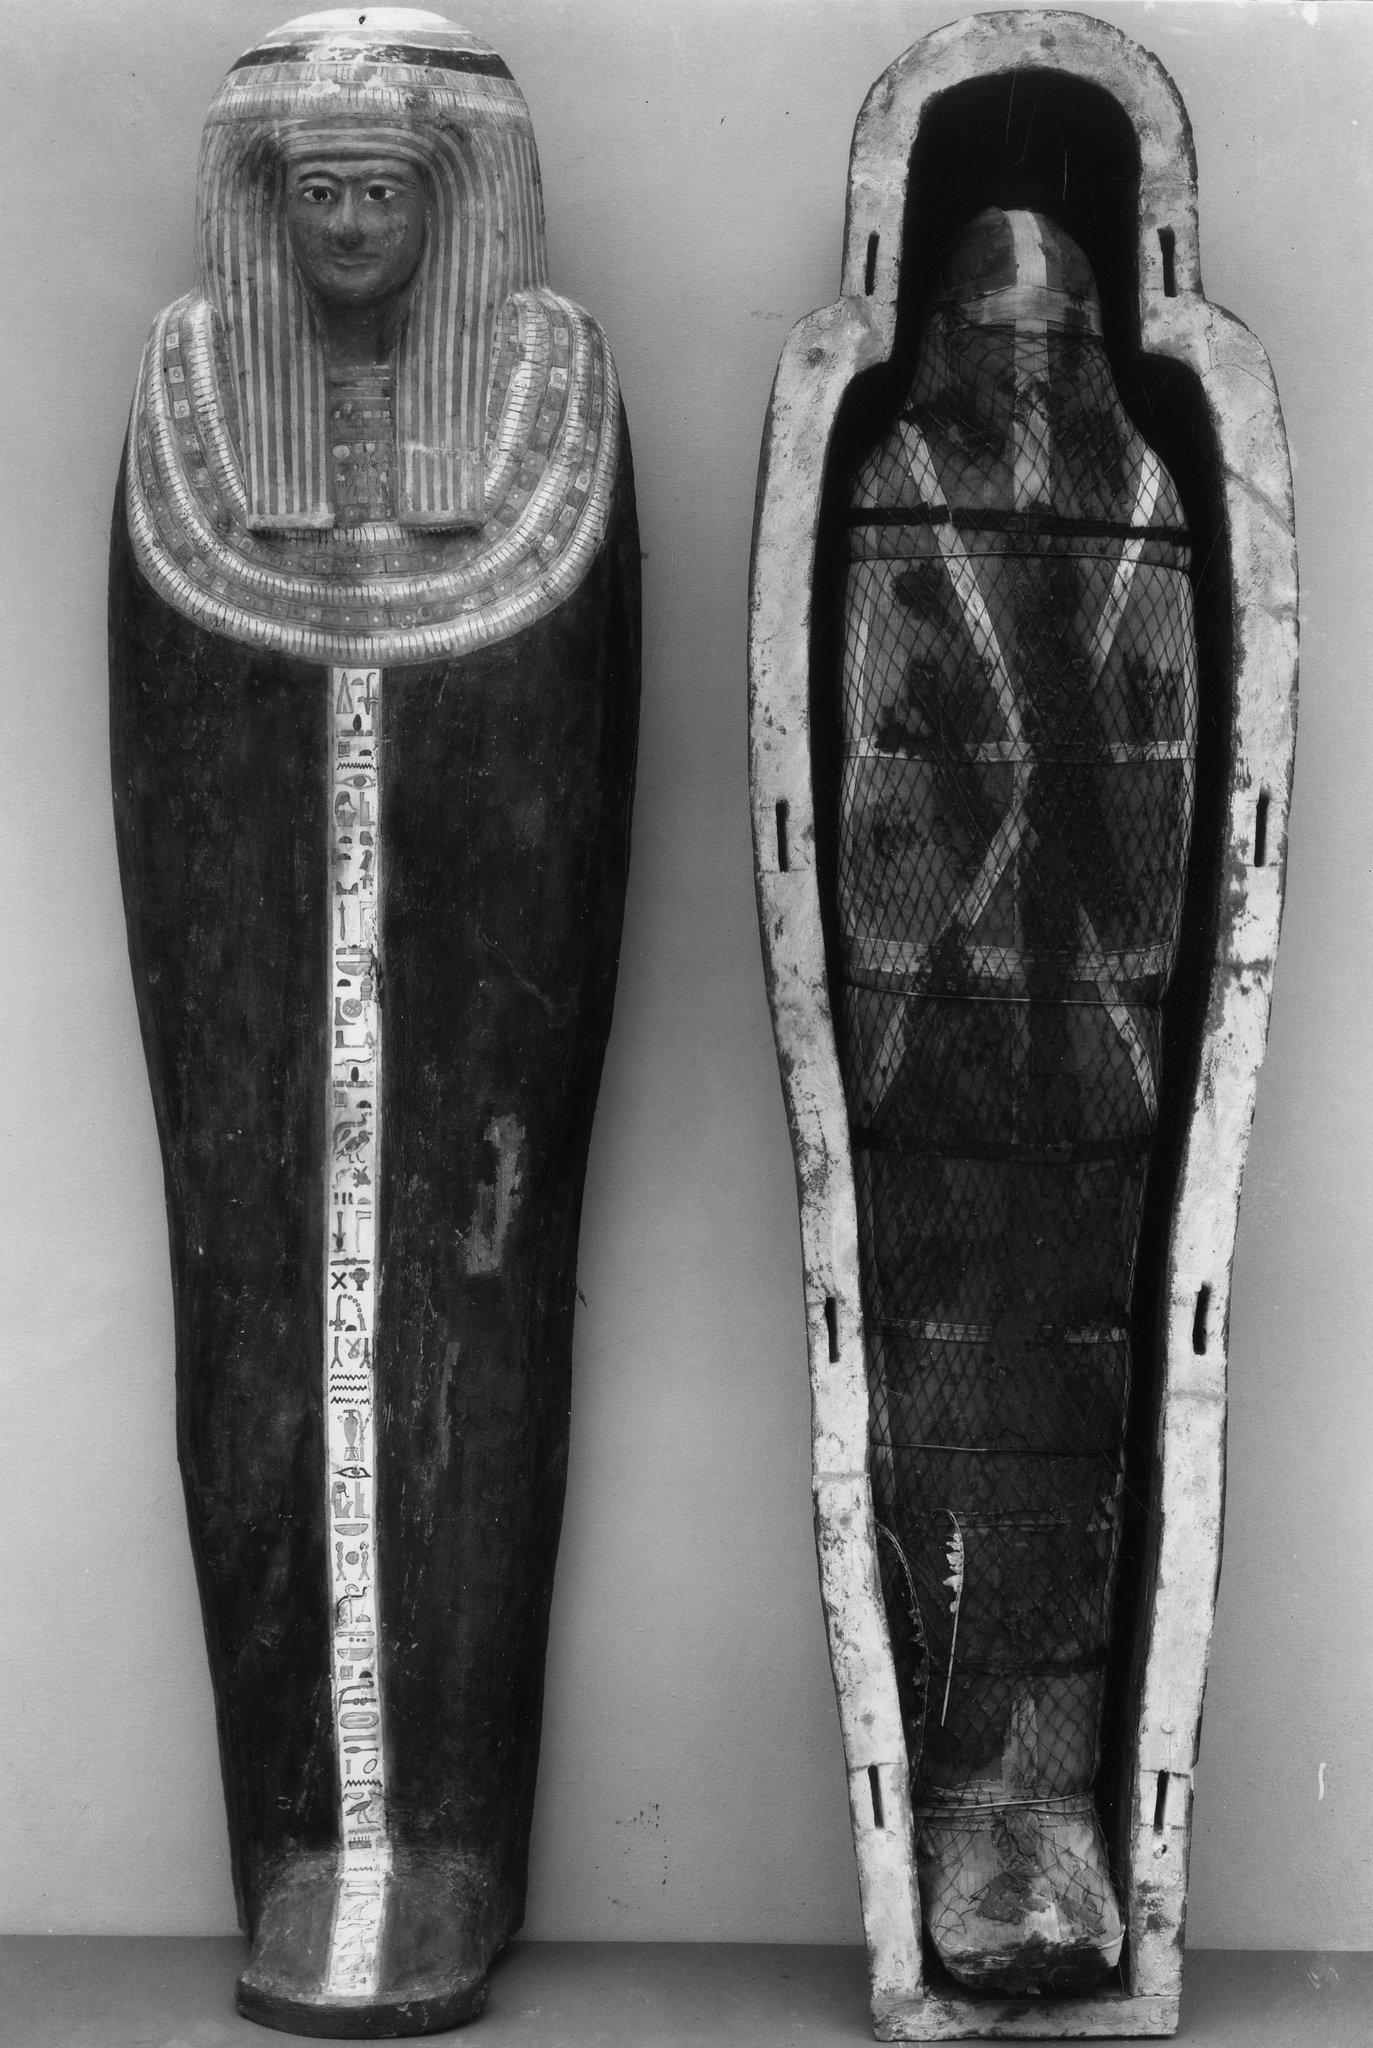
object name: mummy, nesiamun, human remains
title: Mummy of Nesiamun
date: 712-525 BCE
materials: linen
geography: egypt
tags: mummies